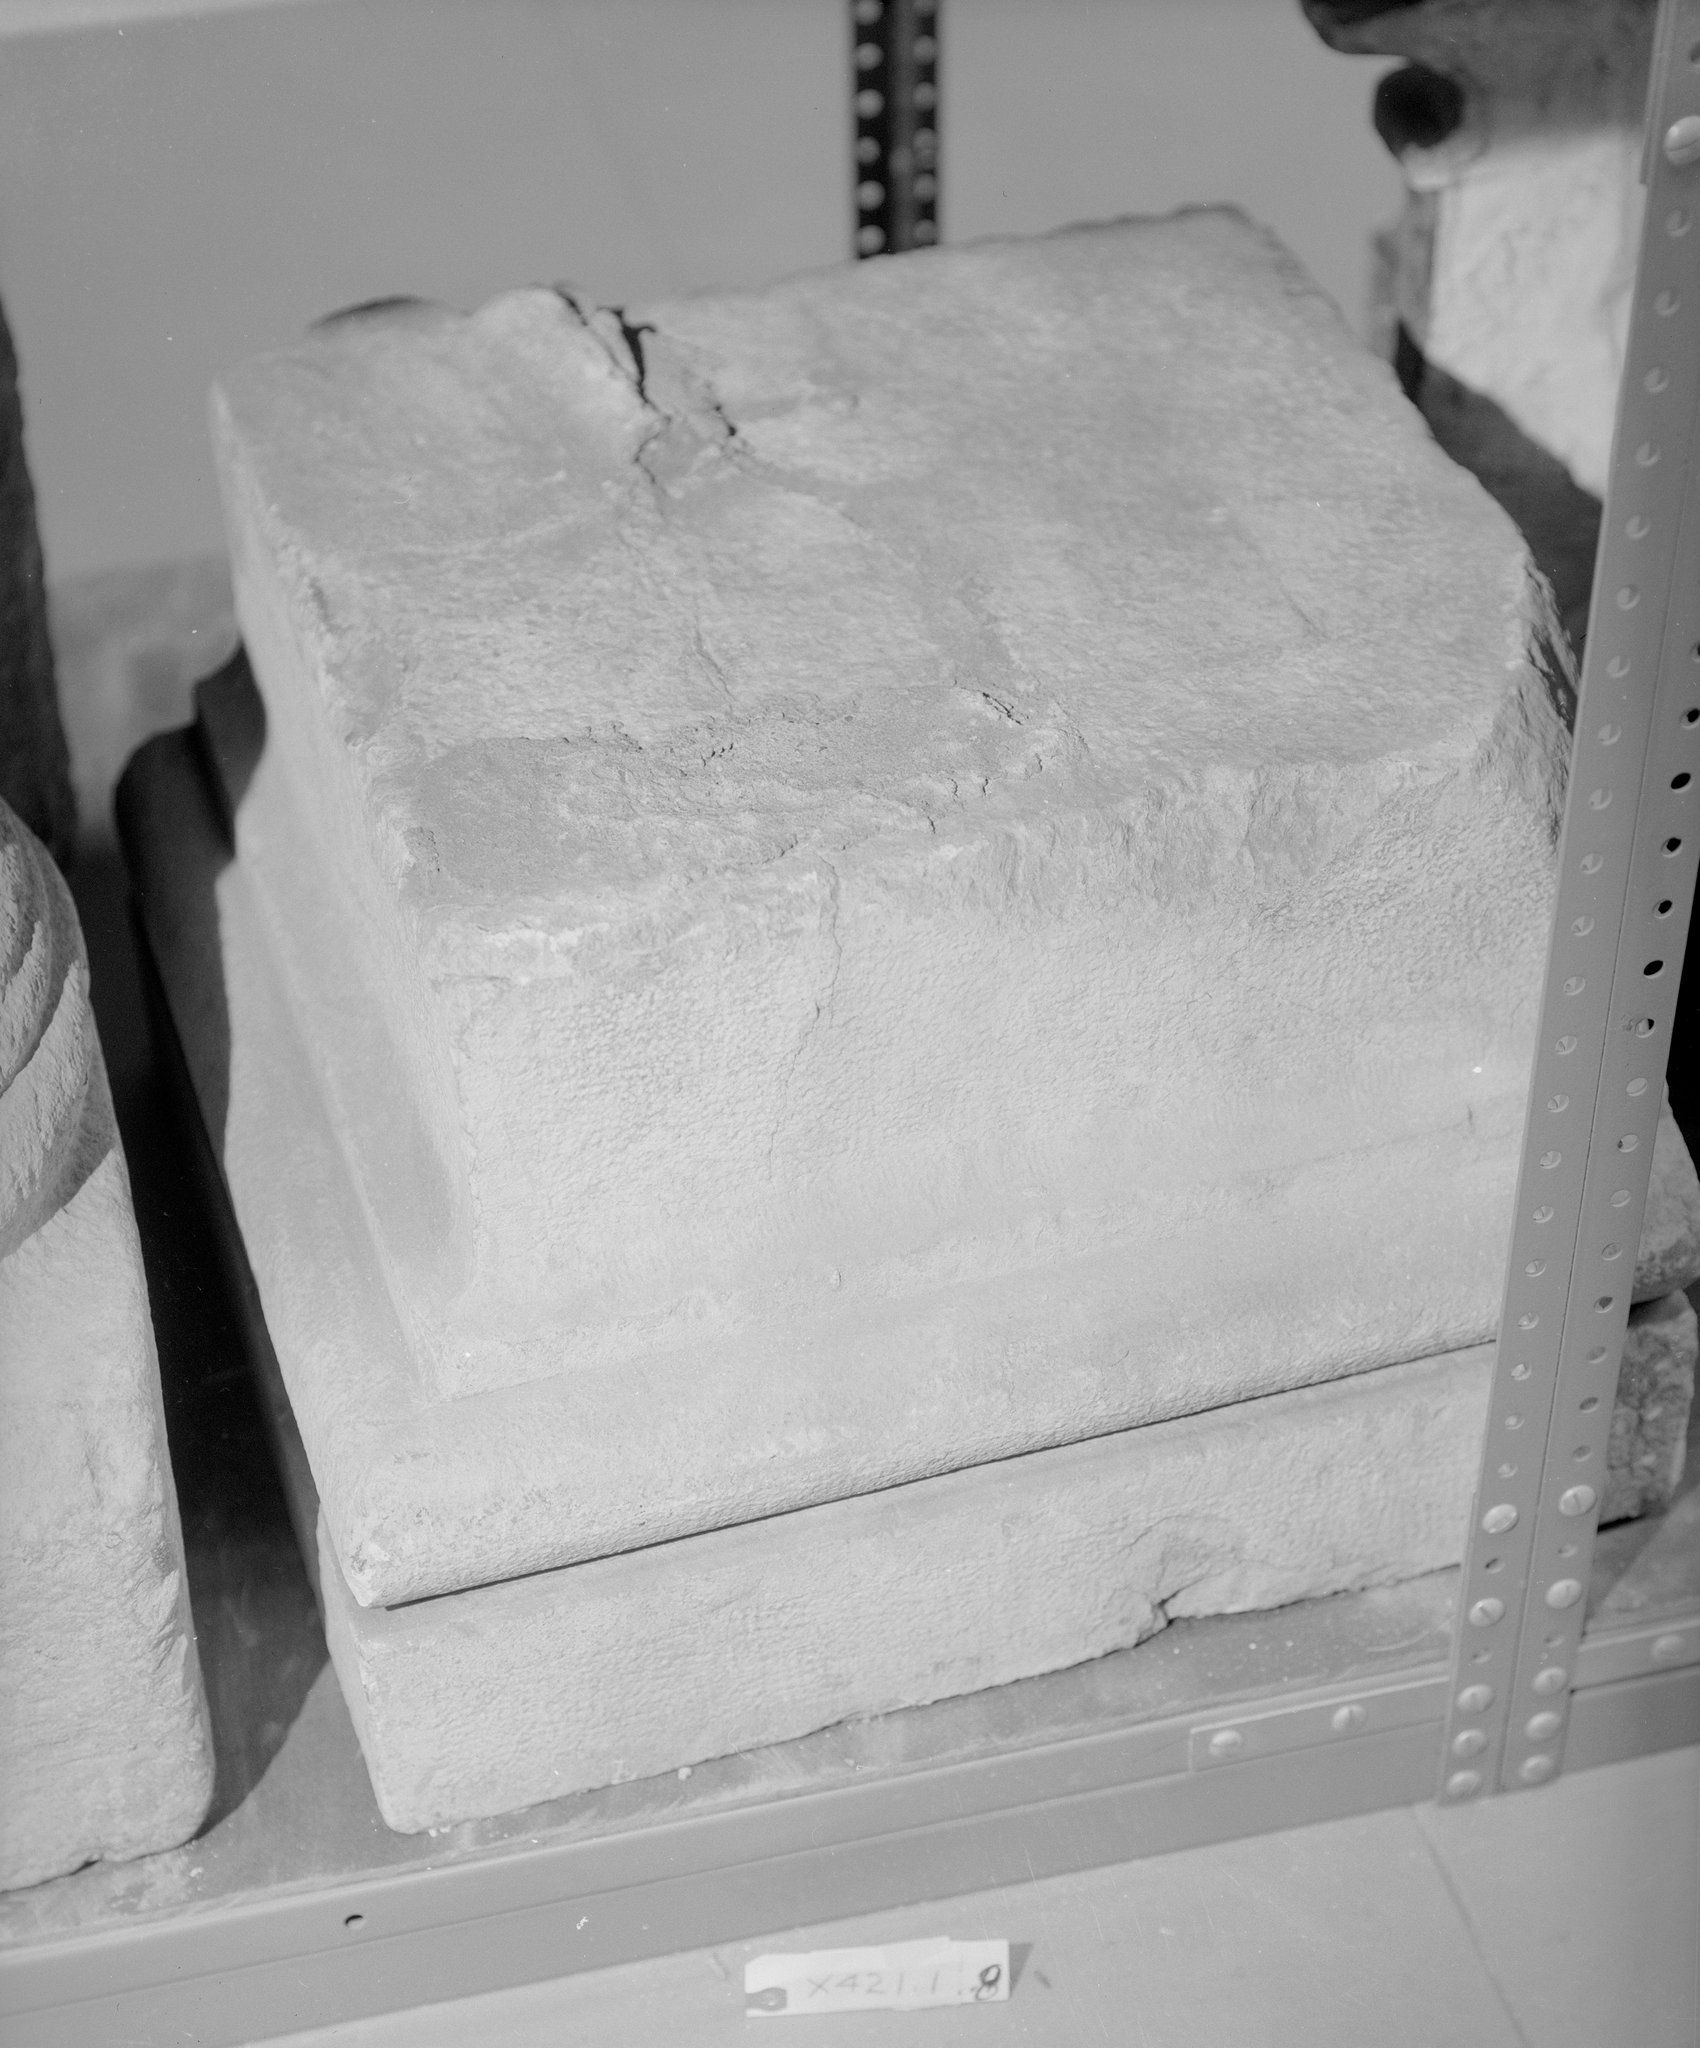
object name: block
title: Parapet Block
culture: french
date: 1130-1140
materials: stone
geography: france